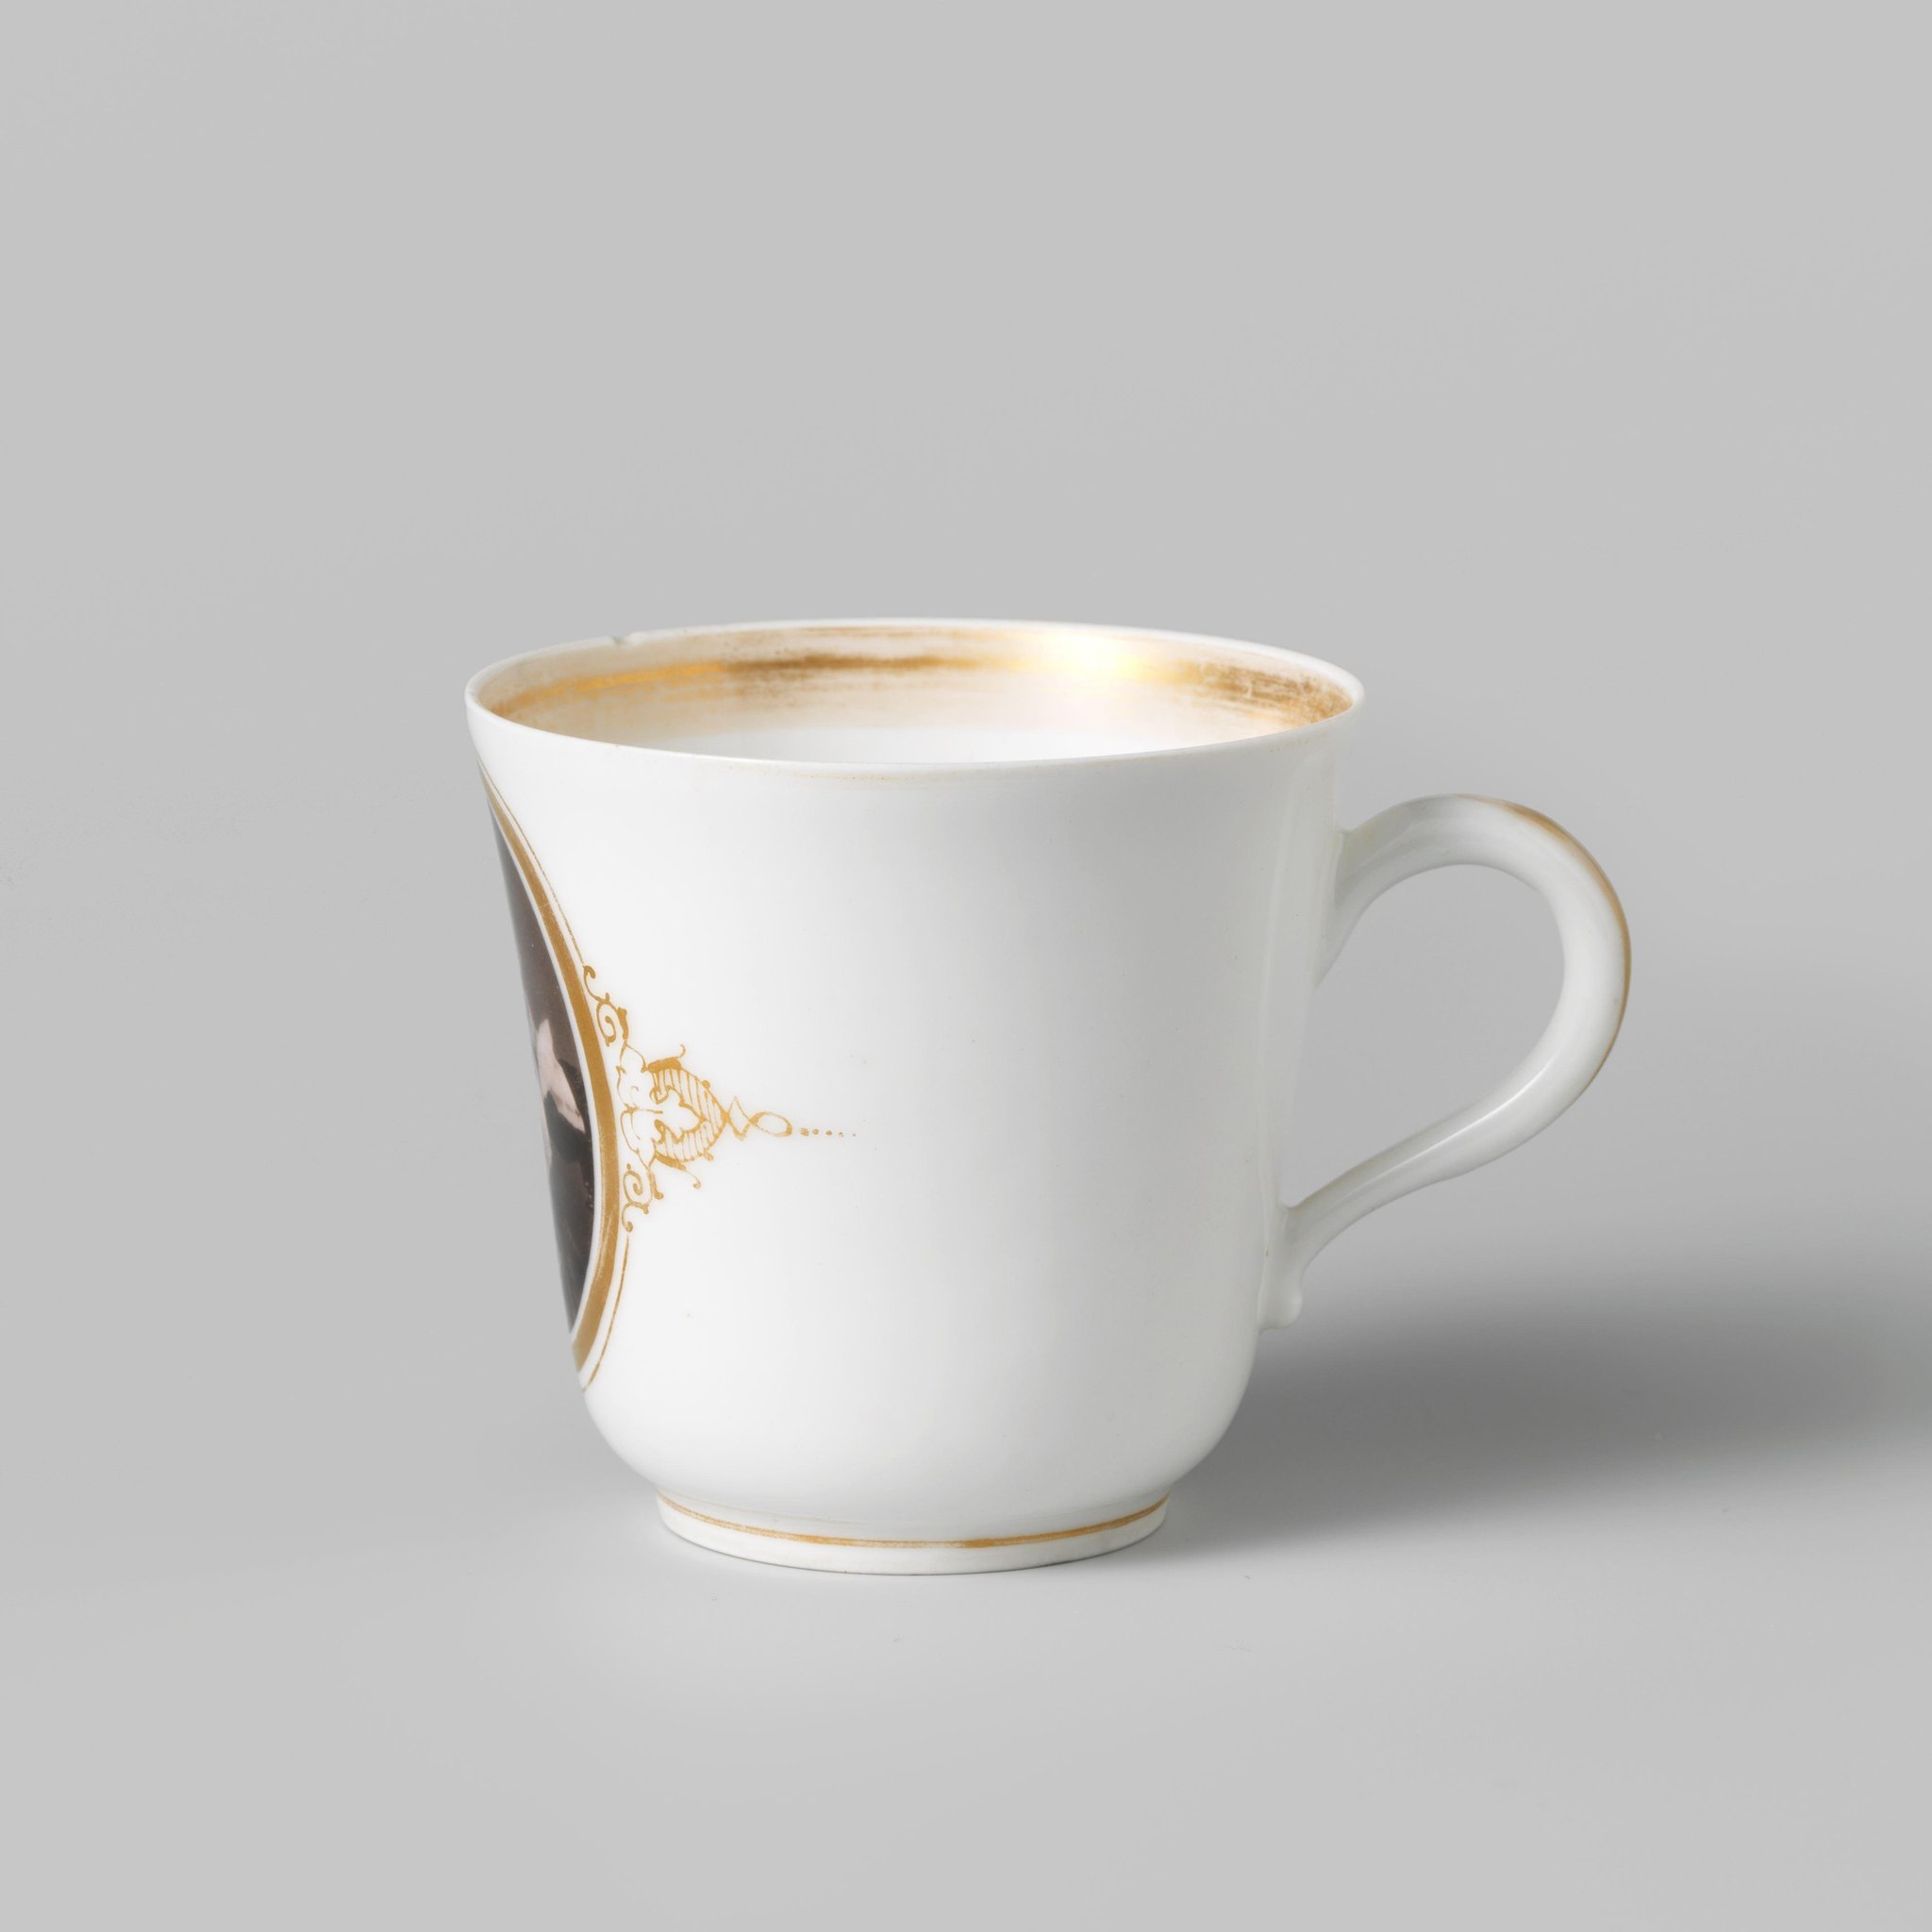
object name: cup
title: Kop met een portret van een dame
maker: Anonymous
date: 1850-1949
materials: ceramic